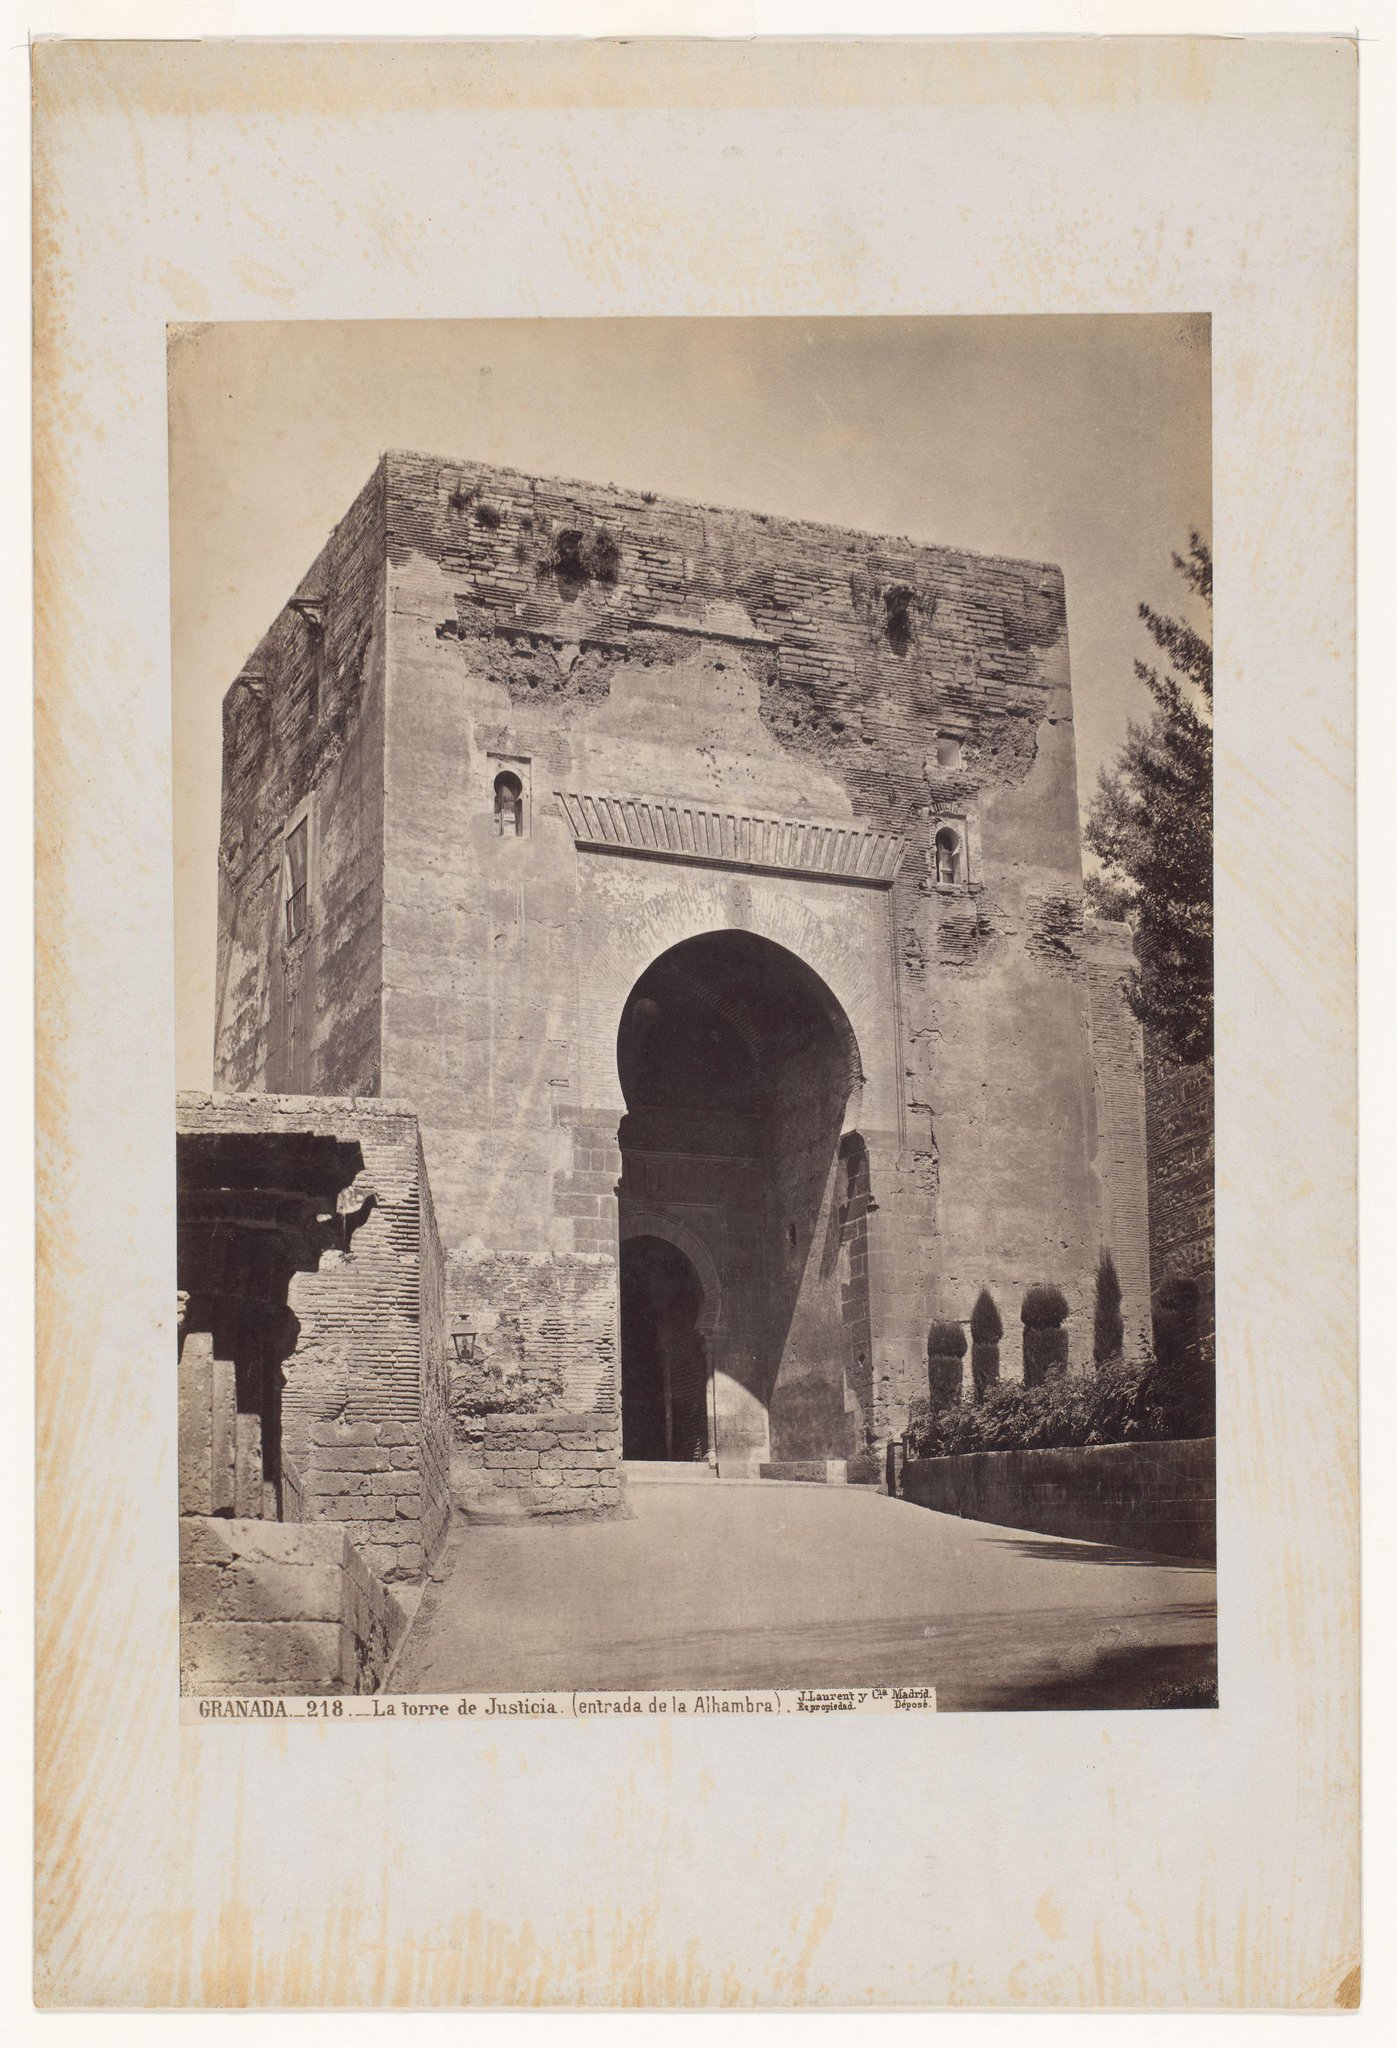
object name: photograph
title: Granada-La torre de Justicia(entrada de la Alhambra)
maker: juan laurent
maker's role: publisher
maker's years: 1816-1896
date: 1857-1880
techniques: albumen print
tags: alhambra